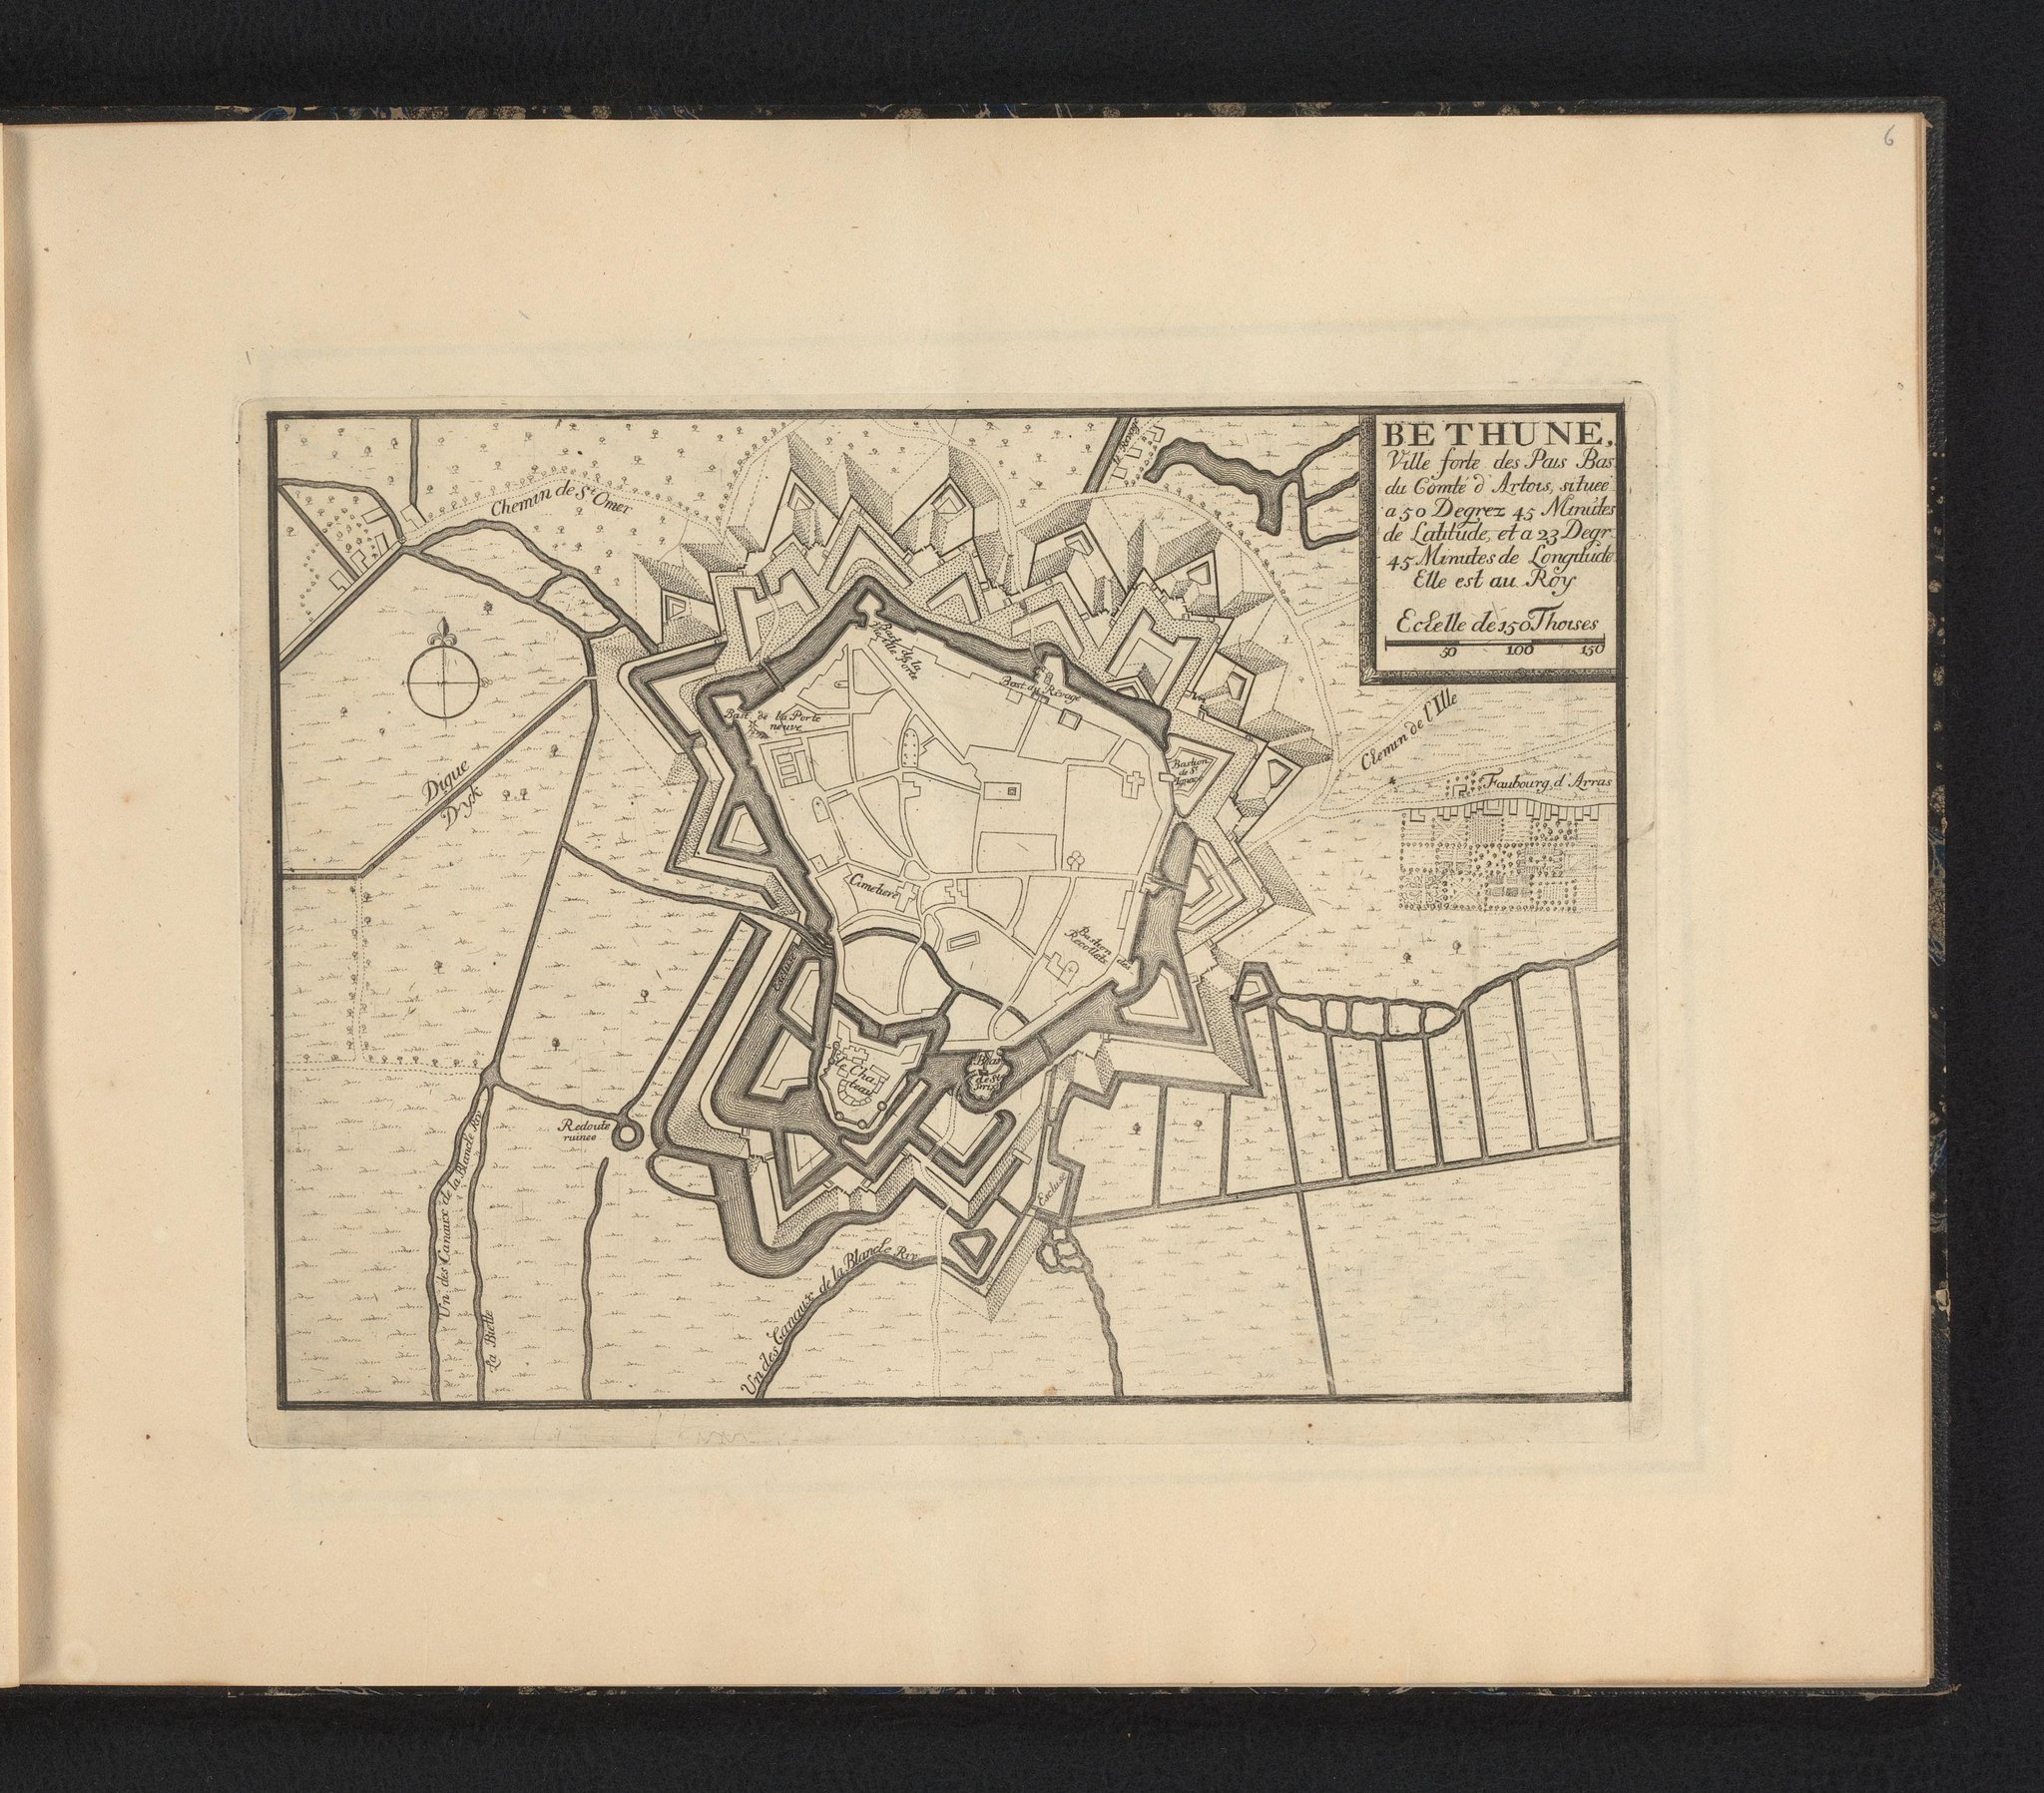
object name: print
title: Le theatre de la guerre, dans les Pays-Bas, ou representation des principales villes qui sont en Flandres, Hainaut, Brabant &c. Avec leurs fortifications (...) premier volume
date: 1693-1696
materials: paper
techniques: etching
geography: paris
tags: fortress, maps of cities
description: Plattegrond van de versterkingen om de stad Béthune in Artois. Maakt deel uit van het eerste deel van het prentwerk: Le Theatre de la Guerre, dans les Pays-Bas, uitgegeven in 1696. Dit deel bevat 25 platen met plannen (afkomstig van Sébastien Le Prestre, Seigneur de Vauban) van vermaarde sterke steden en vestingen in de Negenjarige Oorlog in de Nederlanden. Titel en opschriften in het Frans.